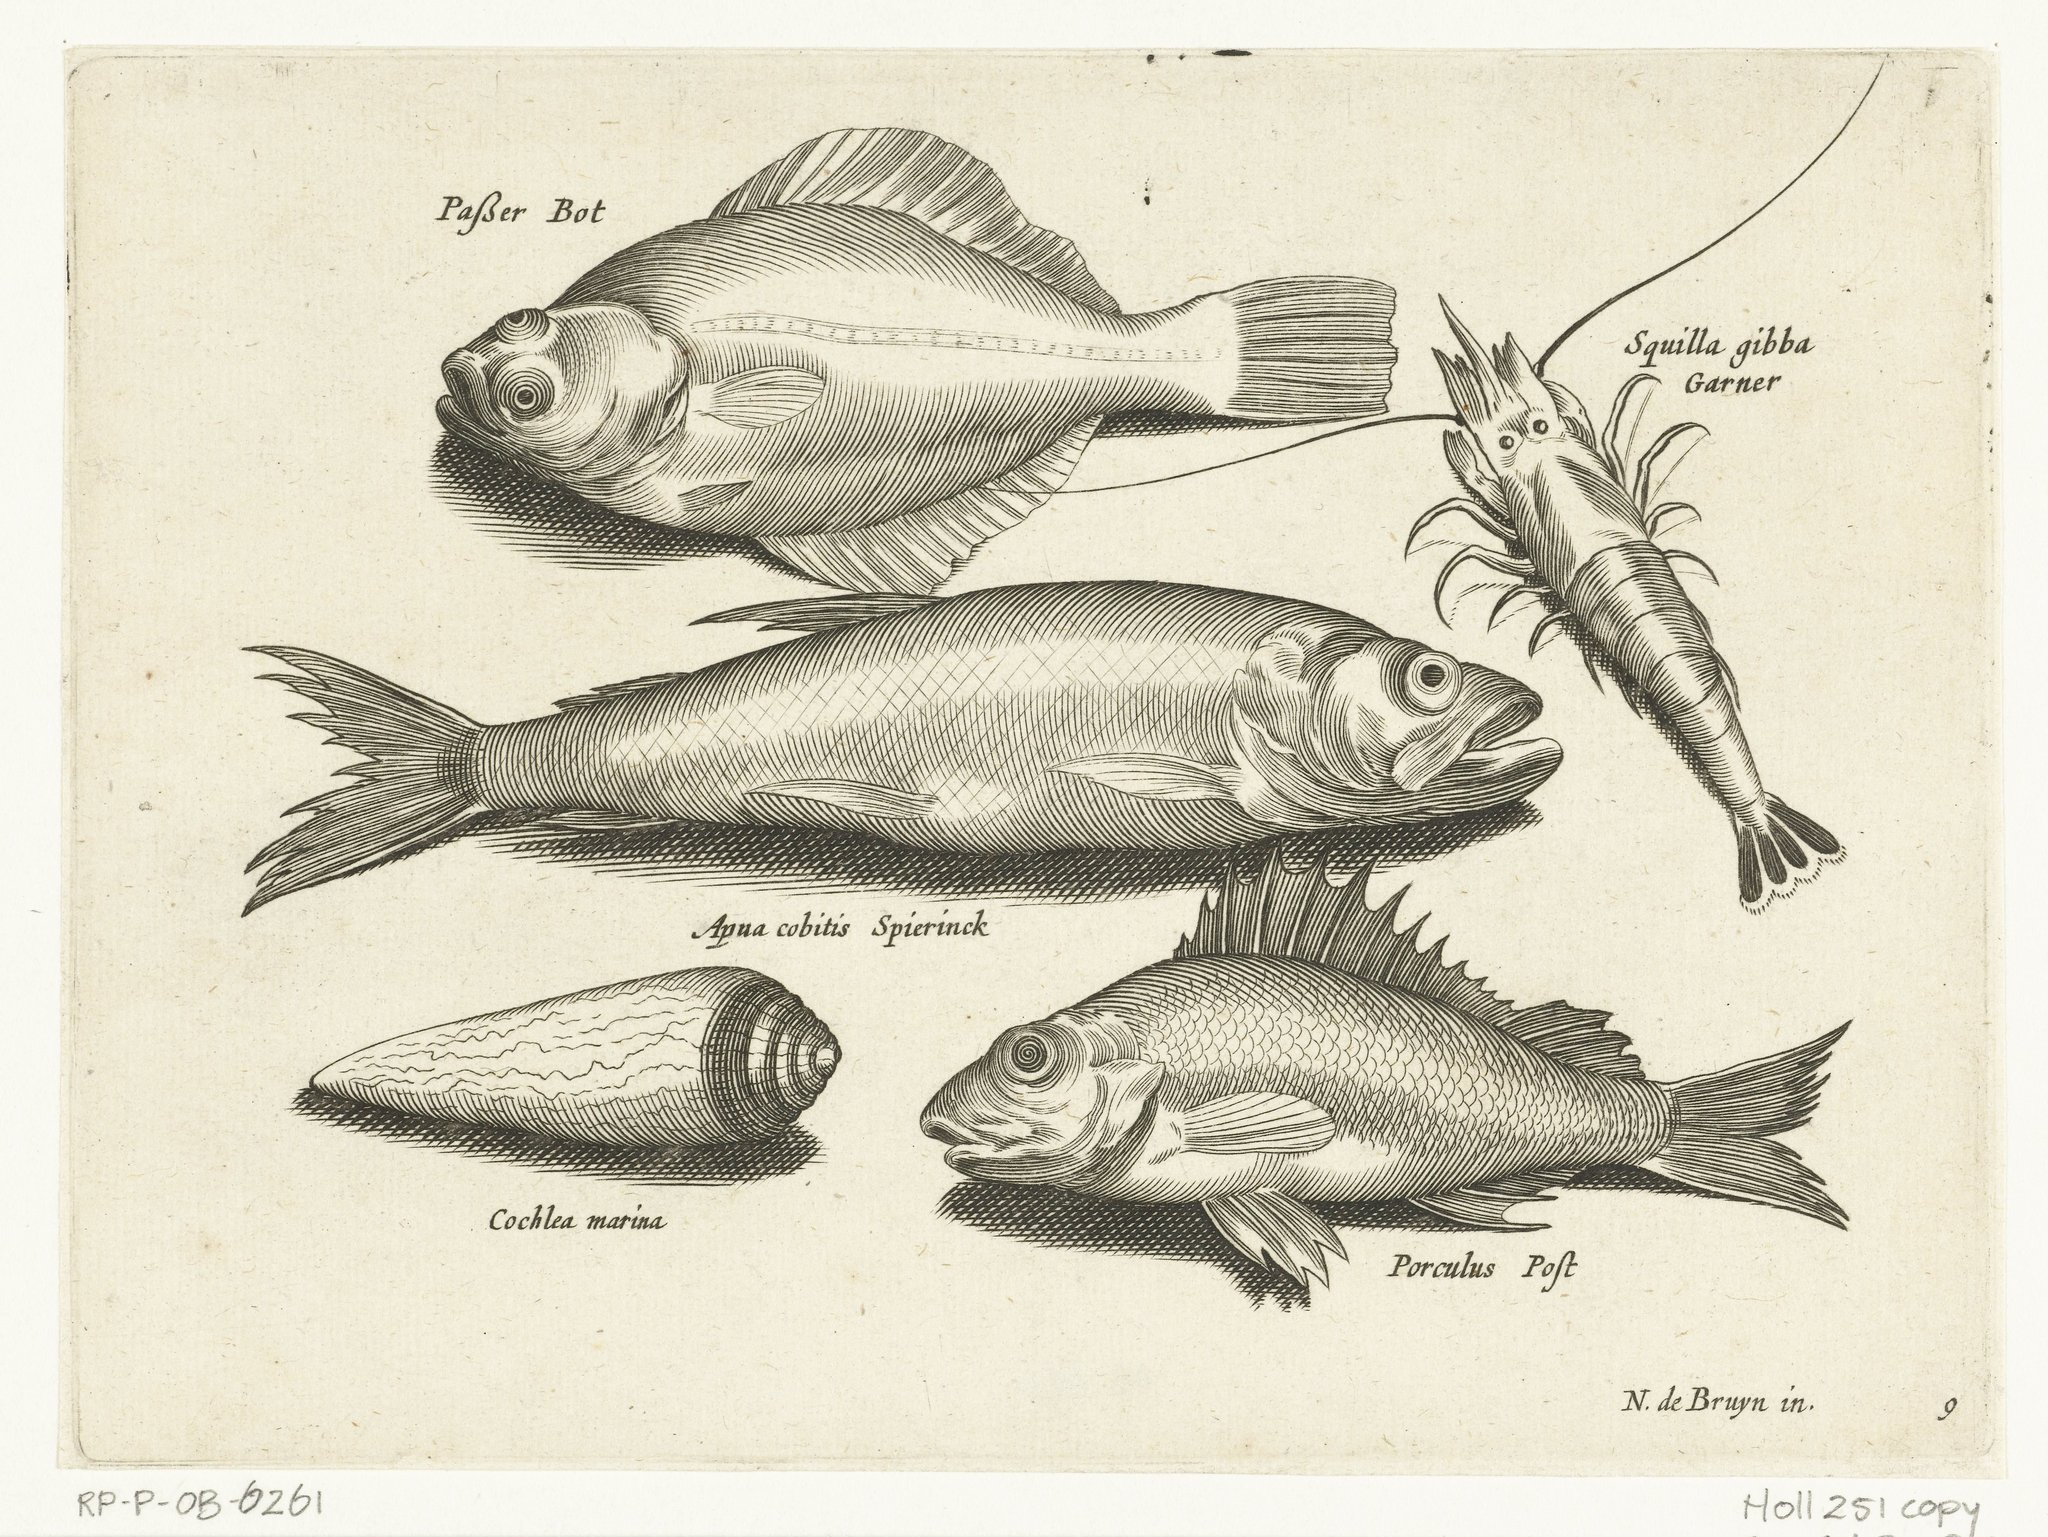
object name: print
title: Zoetwatervissen, zeevissen, kikkers, schaaldieren en zeewezens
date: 1581-1652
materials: paper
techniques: engraving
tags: fishes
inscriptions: collector's mark: Lugt 2228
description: Kopie naar prent van Nicolaas de Bruyn uit serie Libelivs varia Genera piscium complectens van dertien prenten met zoetwatervissen, zeevissen, kikkers, schaaldieren en zeewezens (inclusief titelprent).